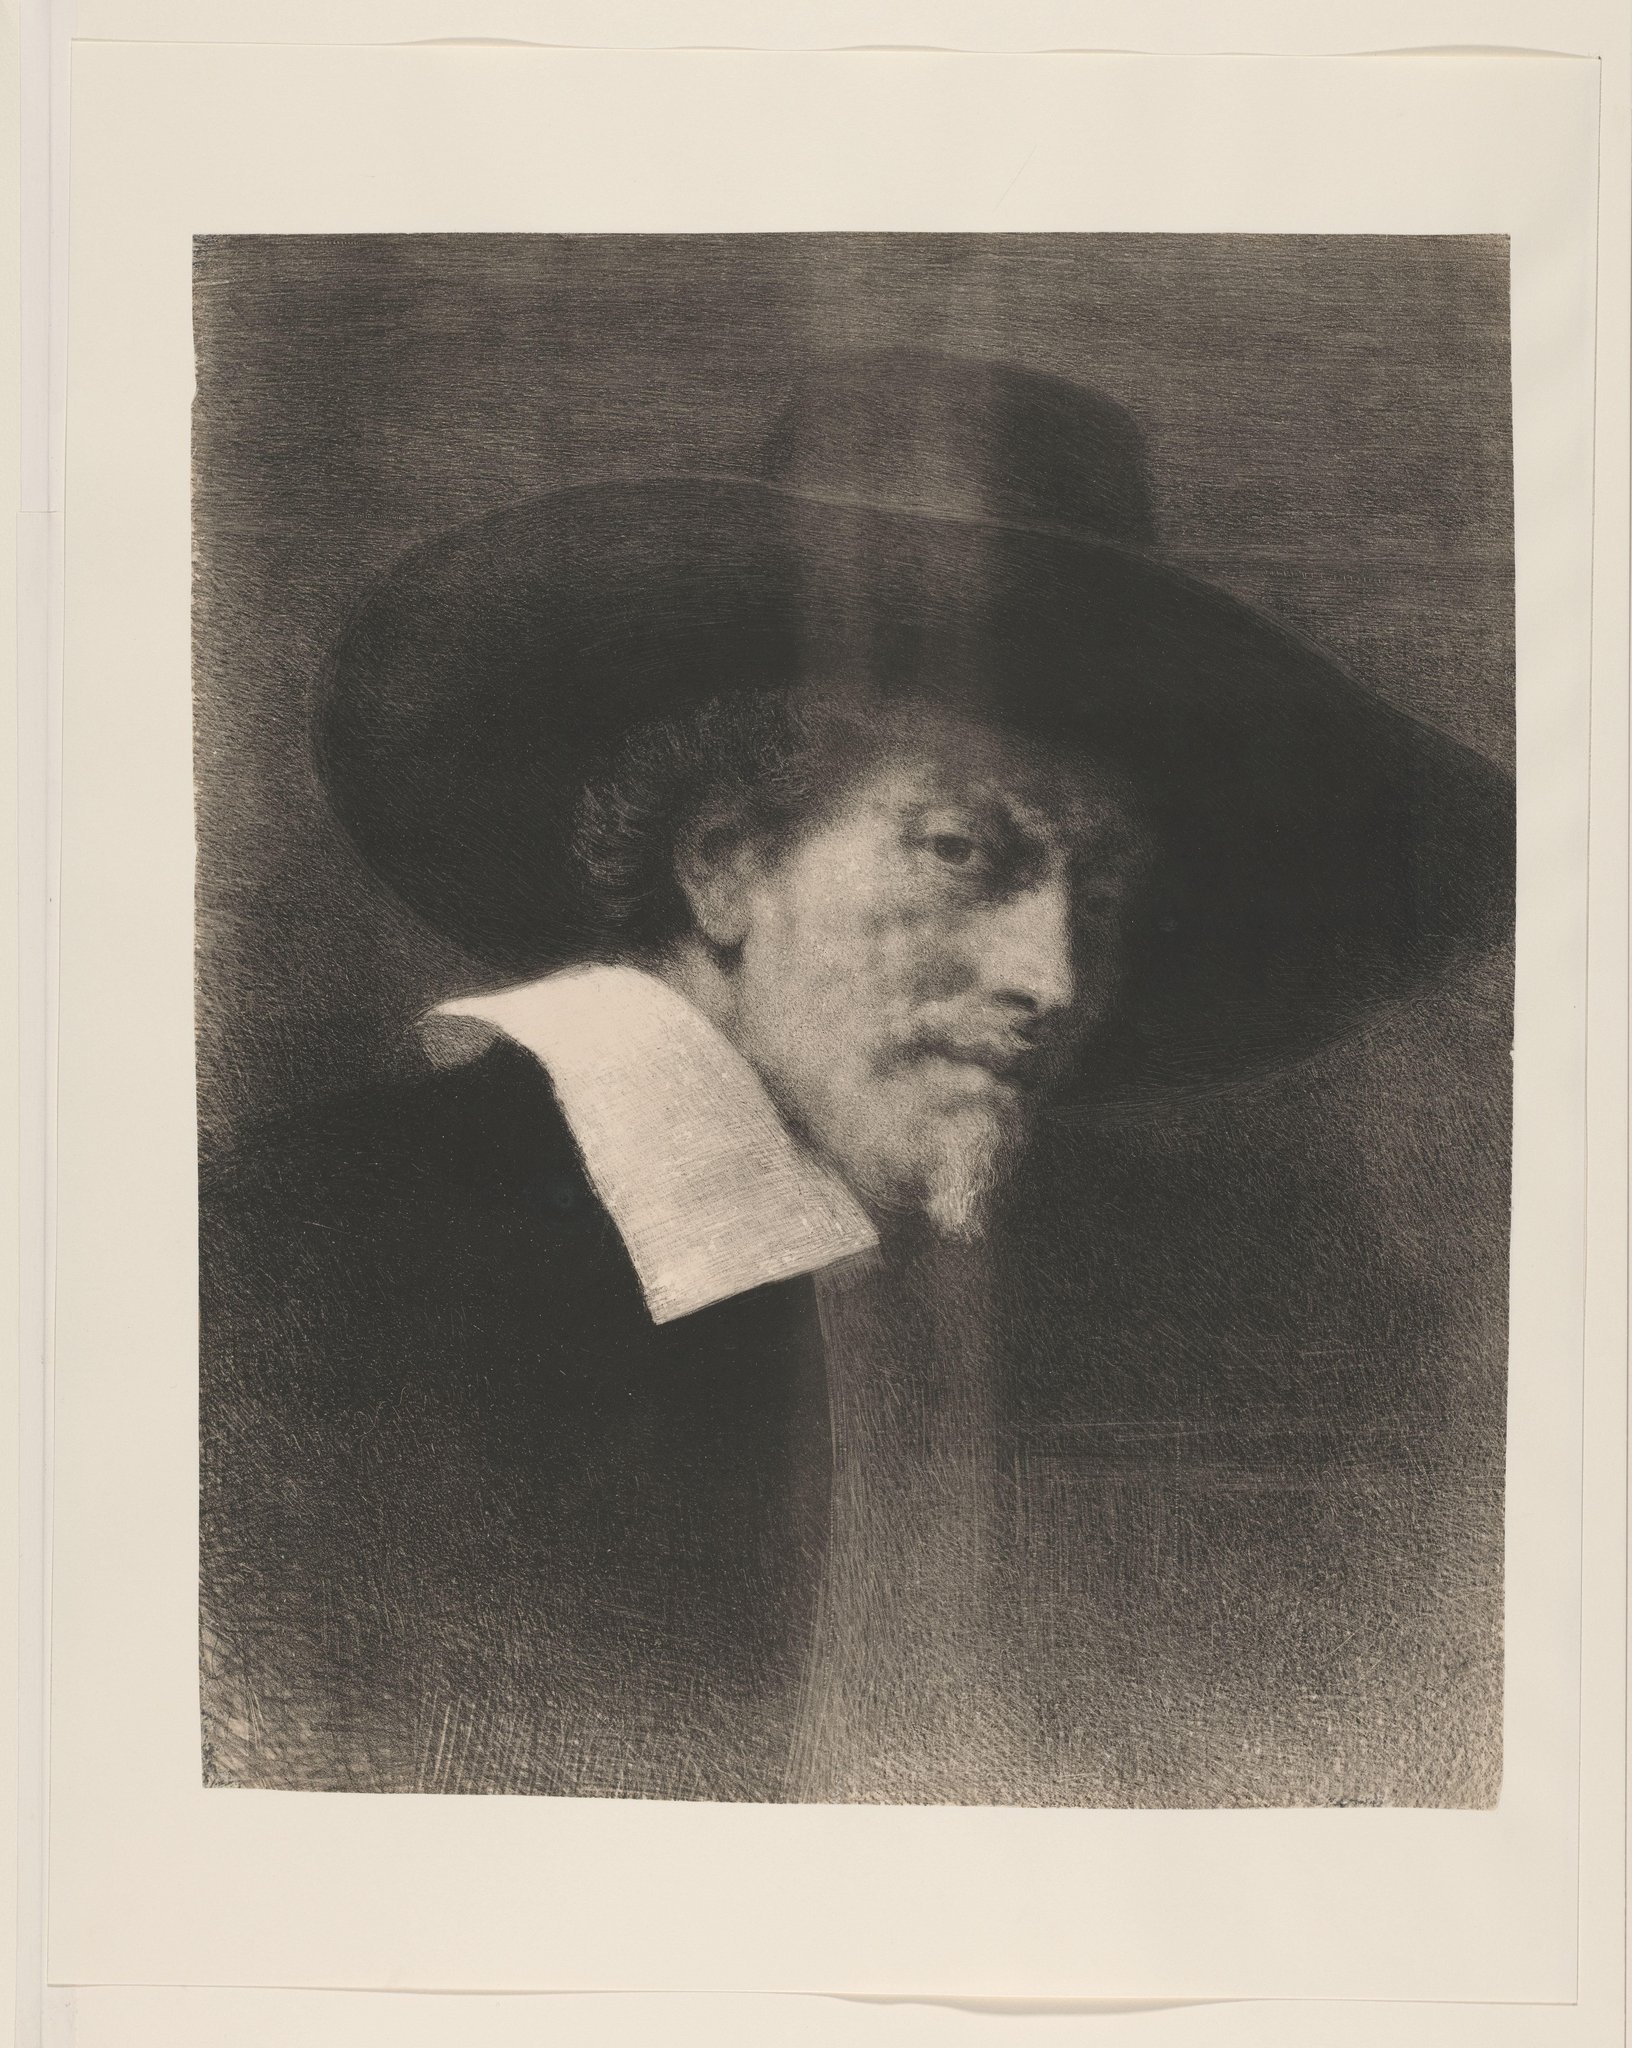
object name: print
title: Detail uit De Staalmeesters van Rembrandt van Rijn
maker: henri j. zimmerman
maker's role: print maker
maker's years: 1825-1886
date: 1835-1886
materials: paper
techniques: lithograph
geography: amsterdam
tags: hoorn (north holland), officers trusted with control of quality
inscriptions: collector's mark: Lugt 2228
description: Gezicht van staalmeester Volckert Jansz.